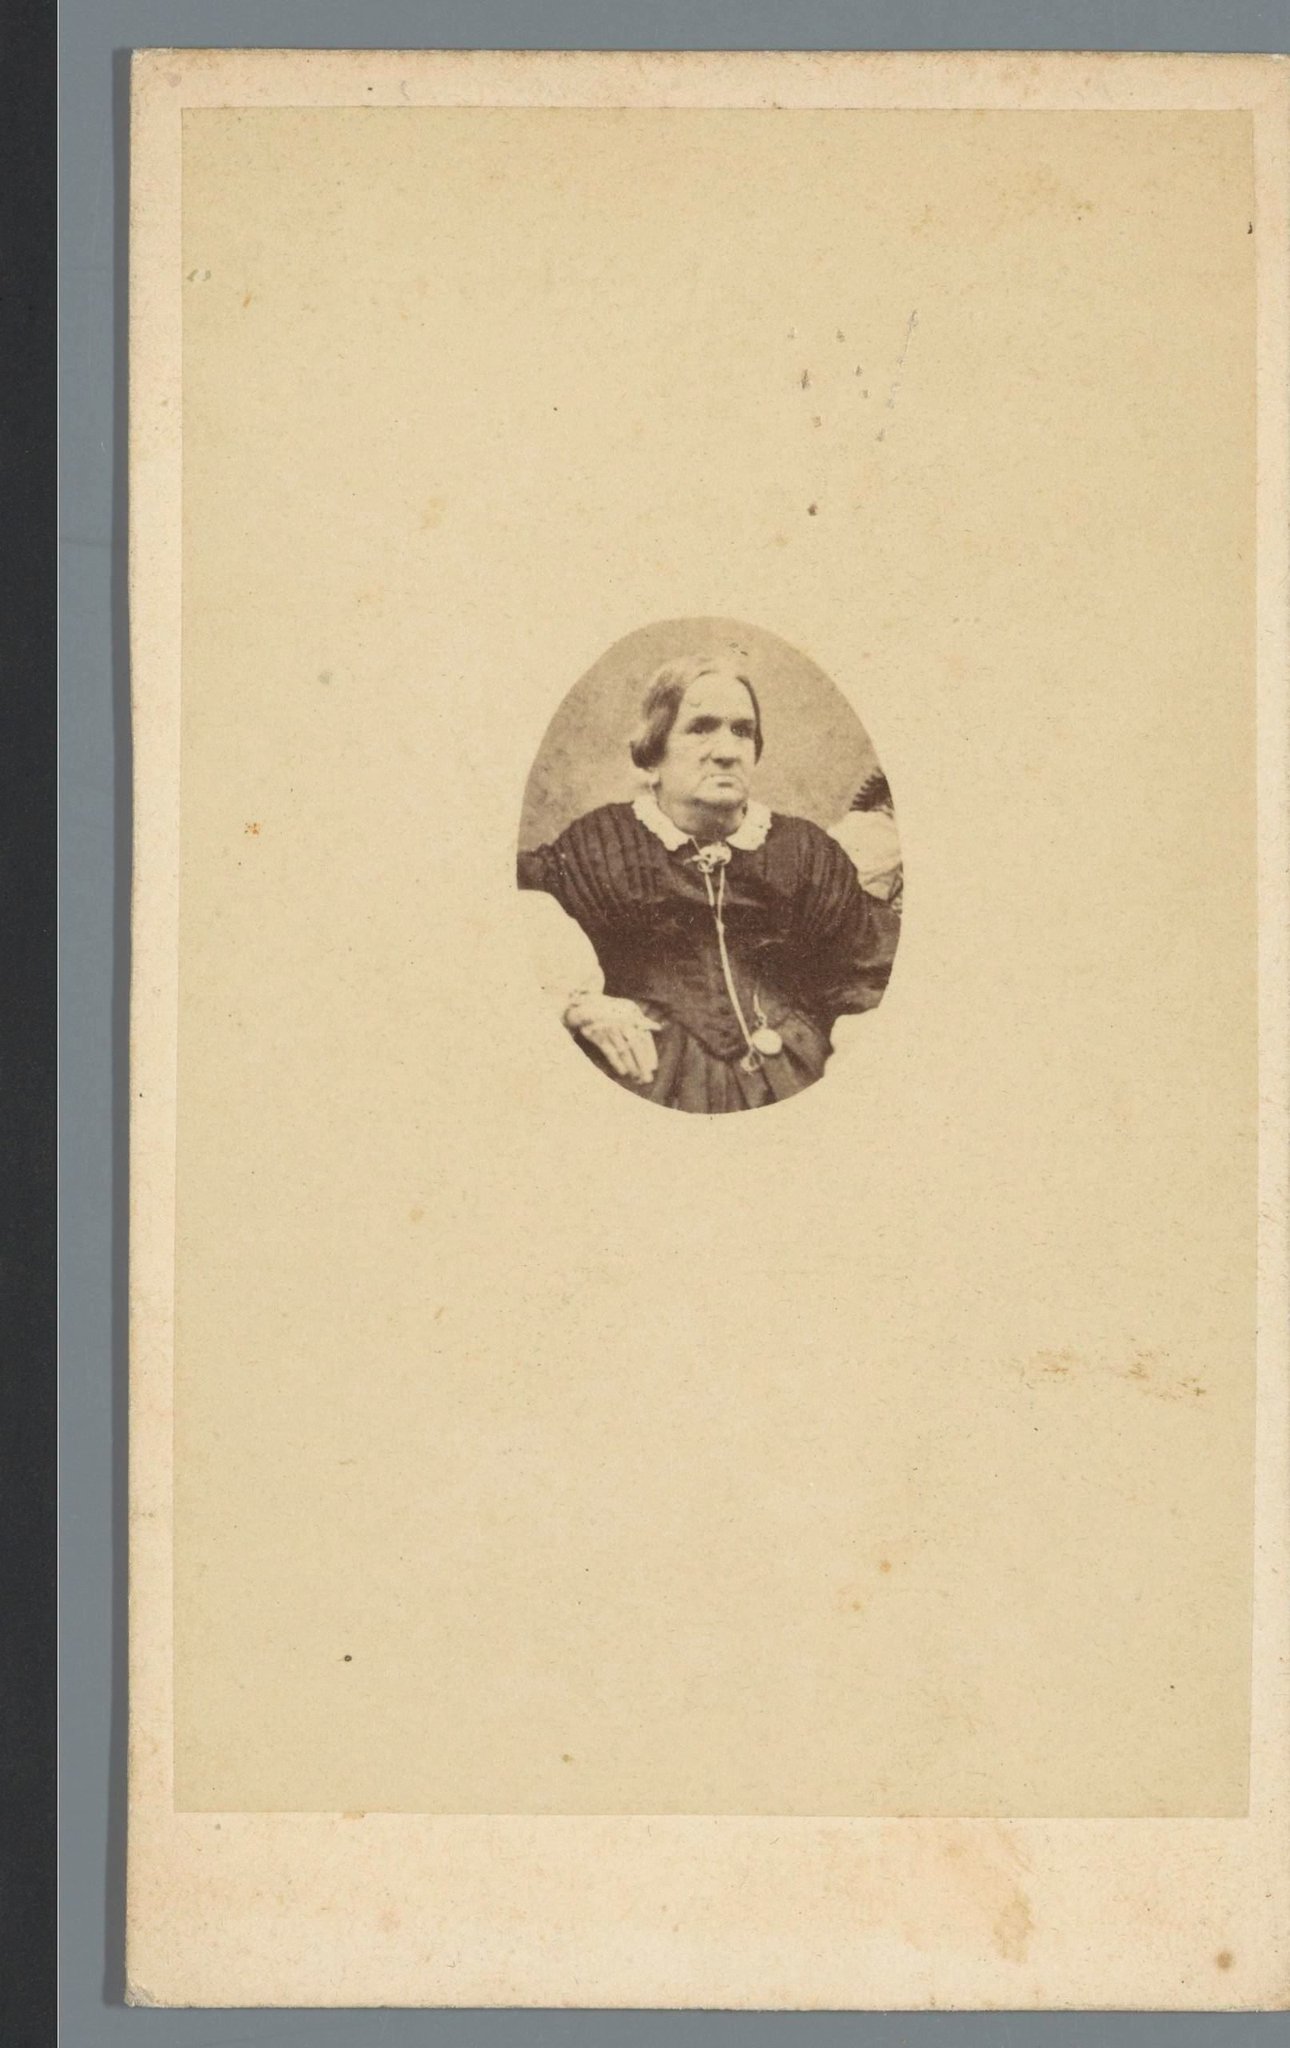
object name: carte de visite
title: Portret van een onbekende vrouw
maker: Anonymous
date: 1855-1885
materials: cardboard, paper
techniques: albumen print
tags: historical persons - bb - woman